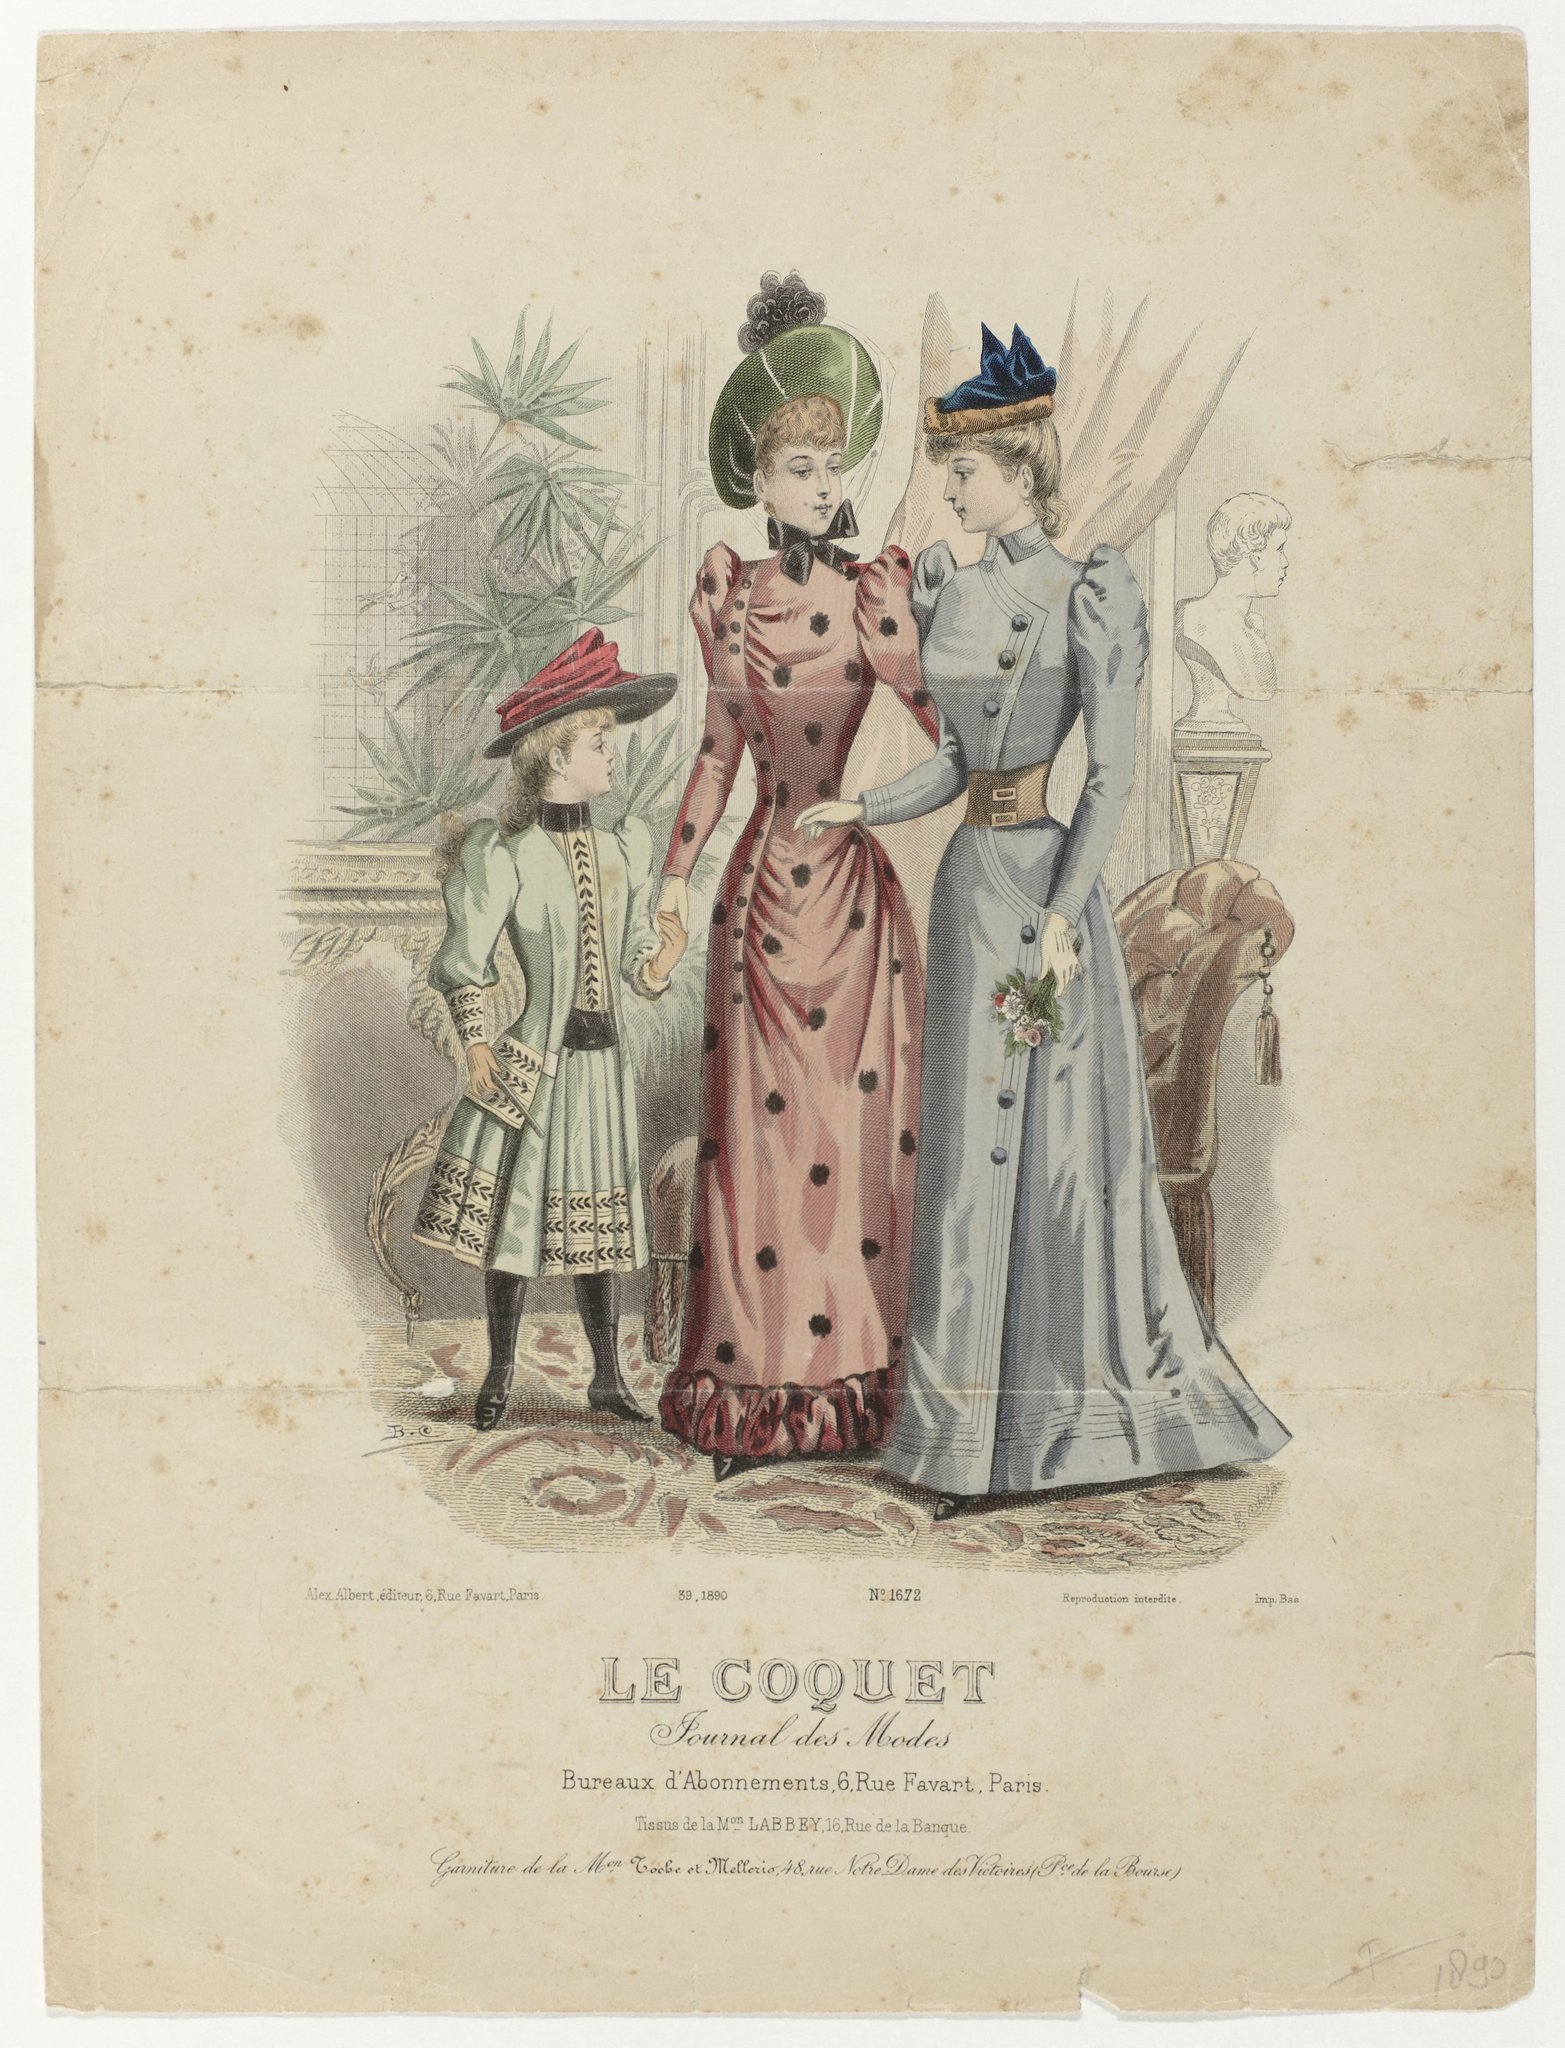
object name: fashion print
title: Le Coquet, 1890, No. 1672 : Garniture de la M.on Toche..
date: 1890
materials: paper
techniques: engraving, hand coloring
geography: paris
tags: cut flowers; nosegay, bunch of flowers, clothes, costume (+ girls' clothes), head-gear: hat (+ girls' clothes), fashion plates, head-gear: hat (+ women's clothes), dress, gown (+ women's clothes), bird in a cage, belt, girdle, waistband (+ women's clothes)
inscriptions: address: ‘Bureaux d'Abonnements,6, Rue Favart, Paris.’, caption: ‘Tissus de la M.on LABBEY, 16, Rue de la Banque. Garniture de la M.on Toche et Mellerio,48, rue Notre Dame des Victoires (P.ce de la Bourse)’, title: ‘LE COQUET / Journal des Modes’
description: Twee vrouwen en een meisje in een interieur met op de achtergrond een vogelkooi. Onder de voorstelling enkele regels reclametekst voor verschillende producten. Prent uit het modetijdschrift Le Coquet (1867-1910).